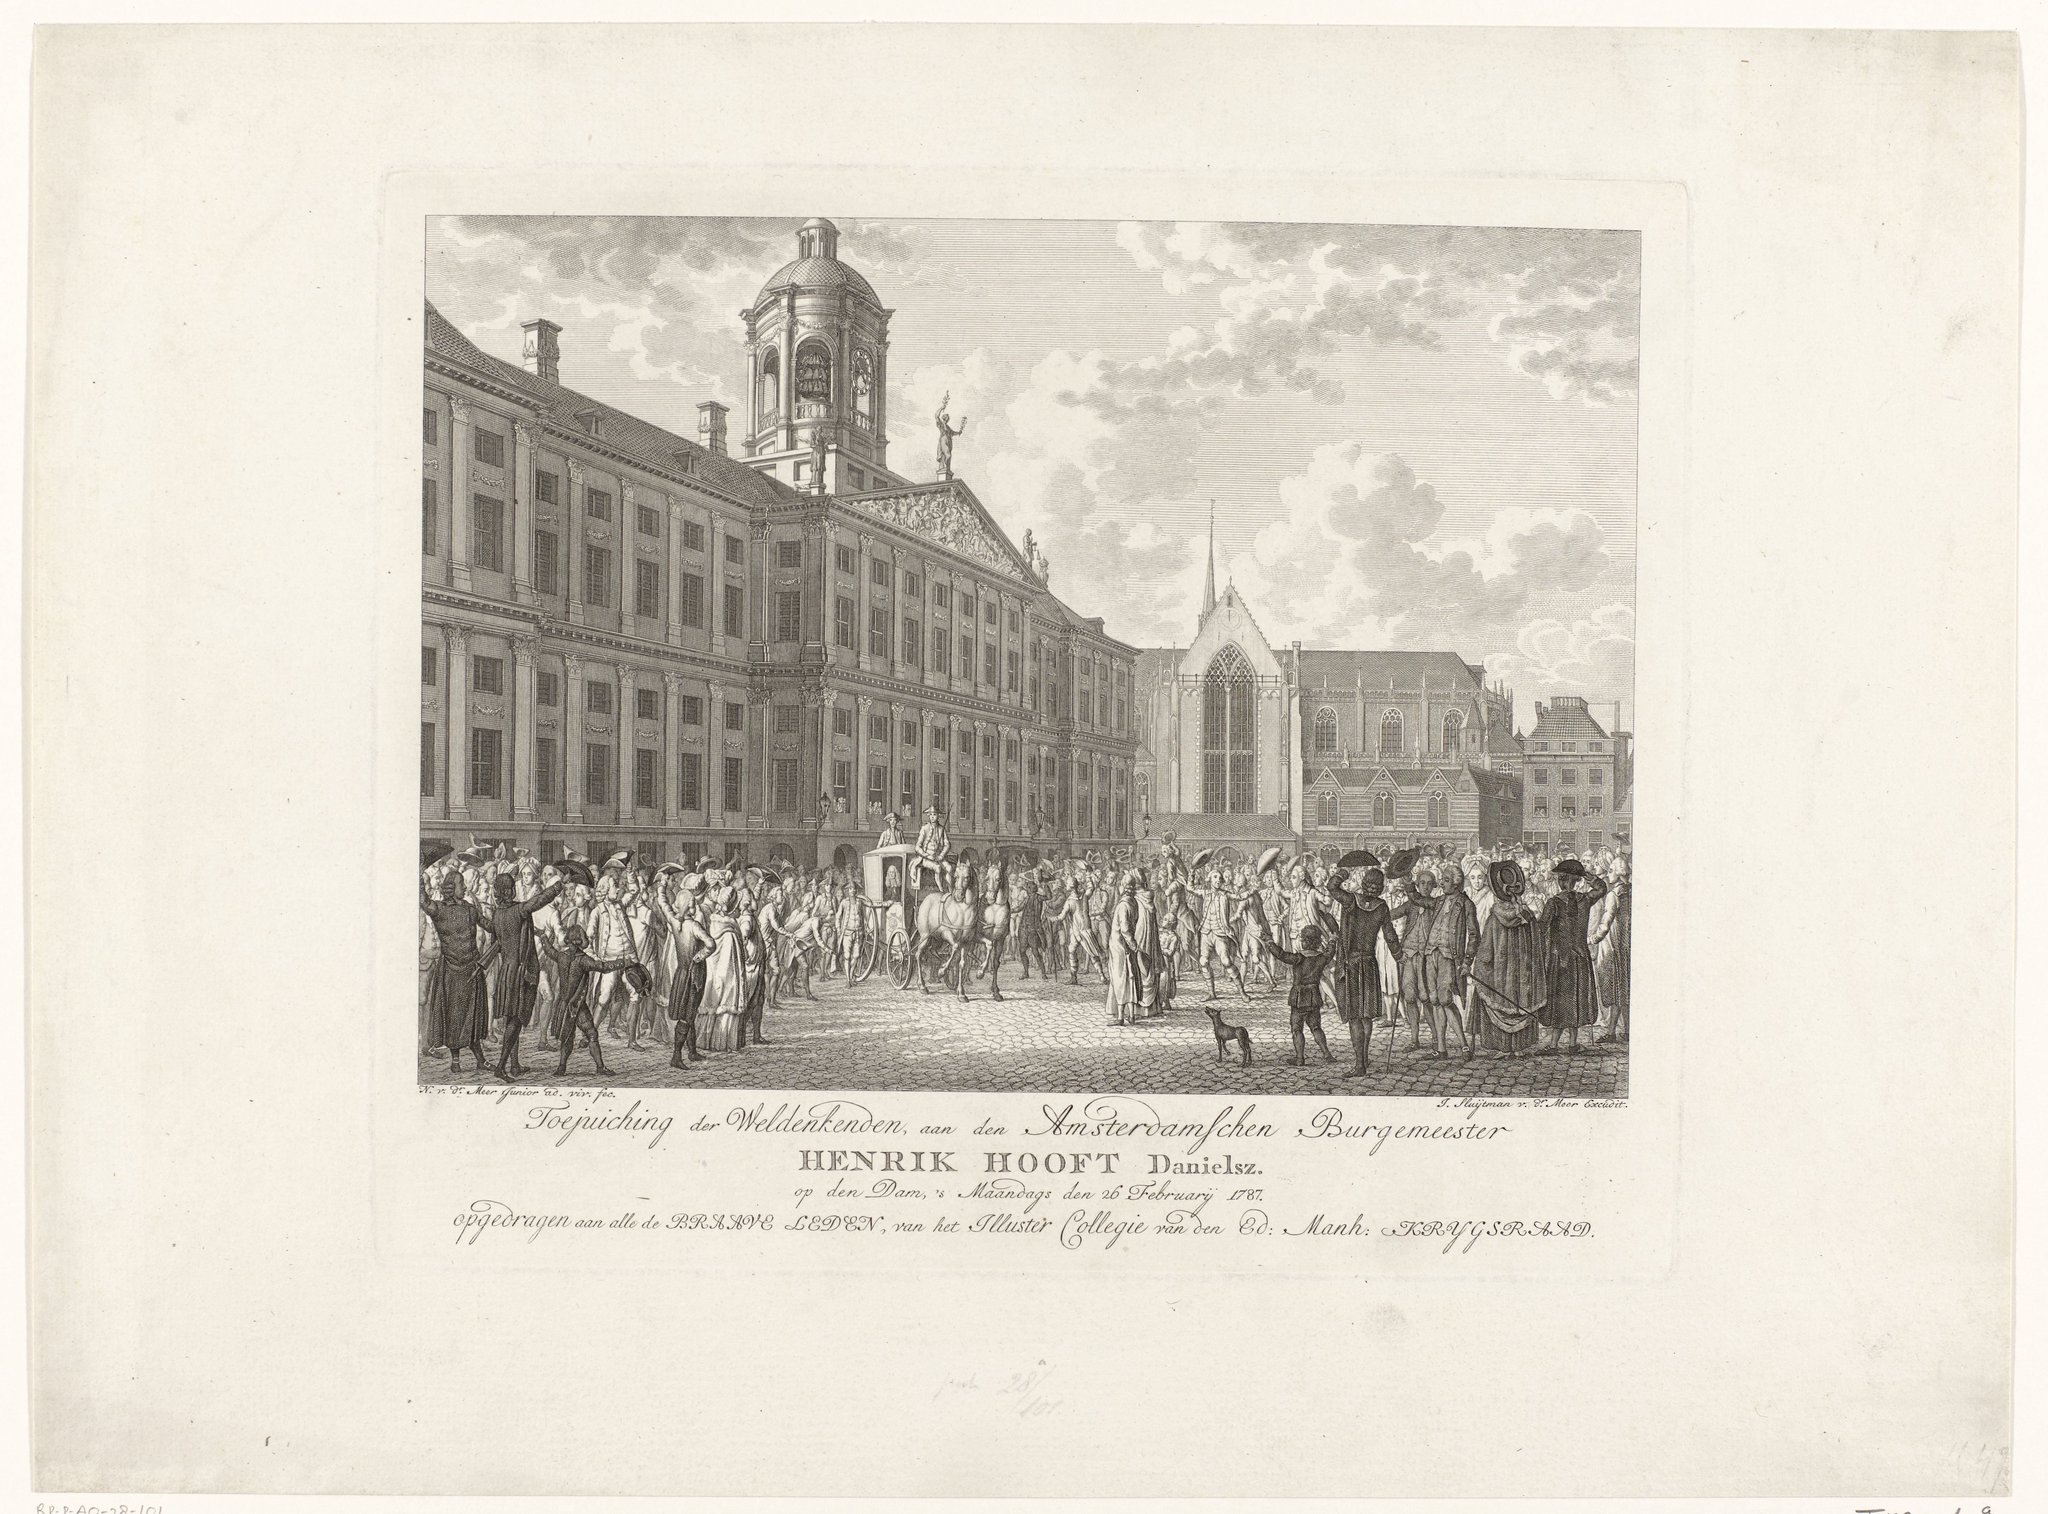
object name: print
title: Toejuiching van Hendrik Danielsz. Hooft op de Dam, 1787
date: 1787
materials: paper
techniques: engraving, etching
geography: amsterdam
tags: amsterdam, mayor, hendrik danielsz. hooft, crowd, mob, mayor, burgomaster, triumphal entry and public reception, pageant, 'entrée solennelle', 'joyeuse entrée', patriots (1780-1795)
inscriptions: collector's mark: Lugt 2228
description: De Amsterdamse burgemeester Hendrik Danielsz. Hooft wordt bij vertrek in zijn rijtuig toegejuicht door het publiek op de Dam, 26 februari 1787.